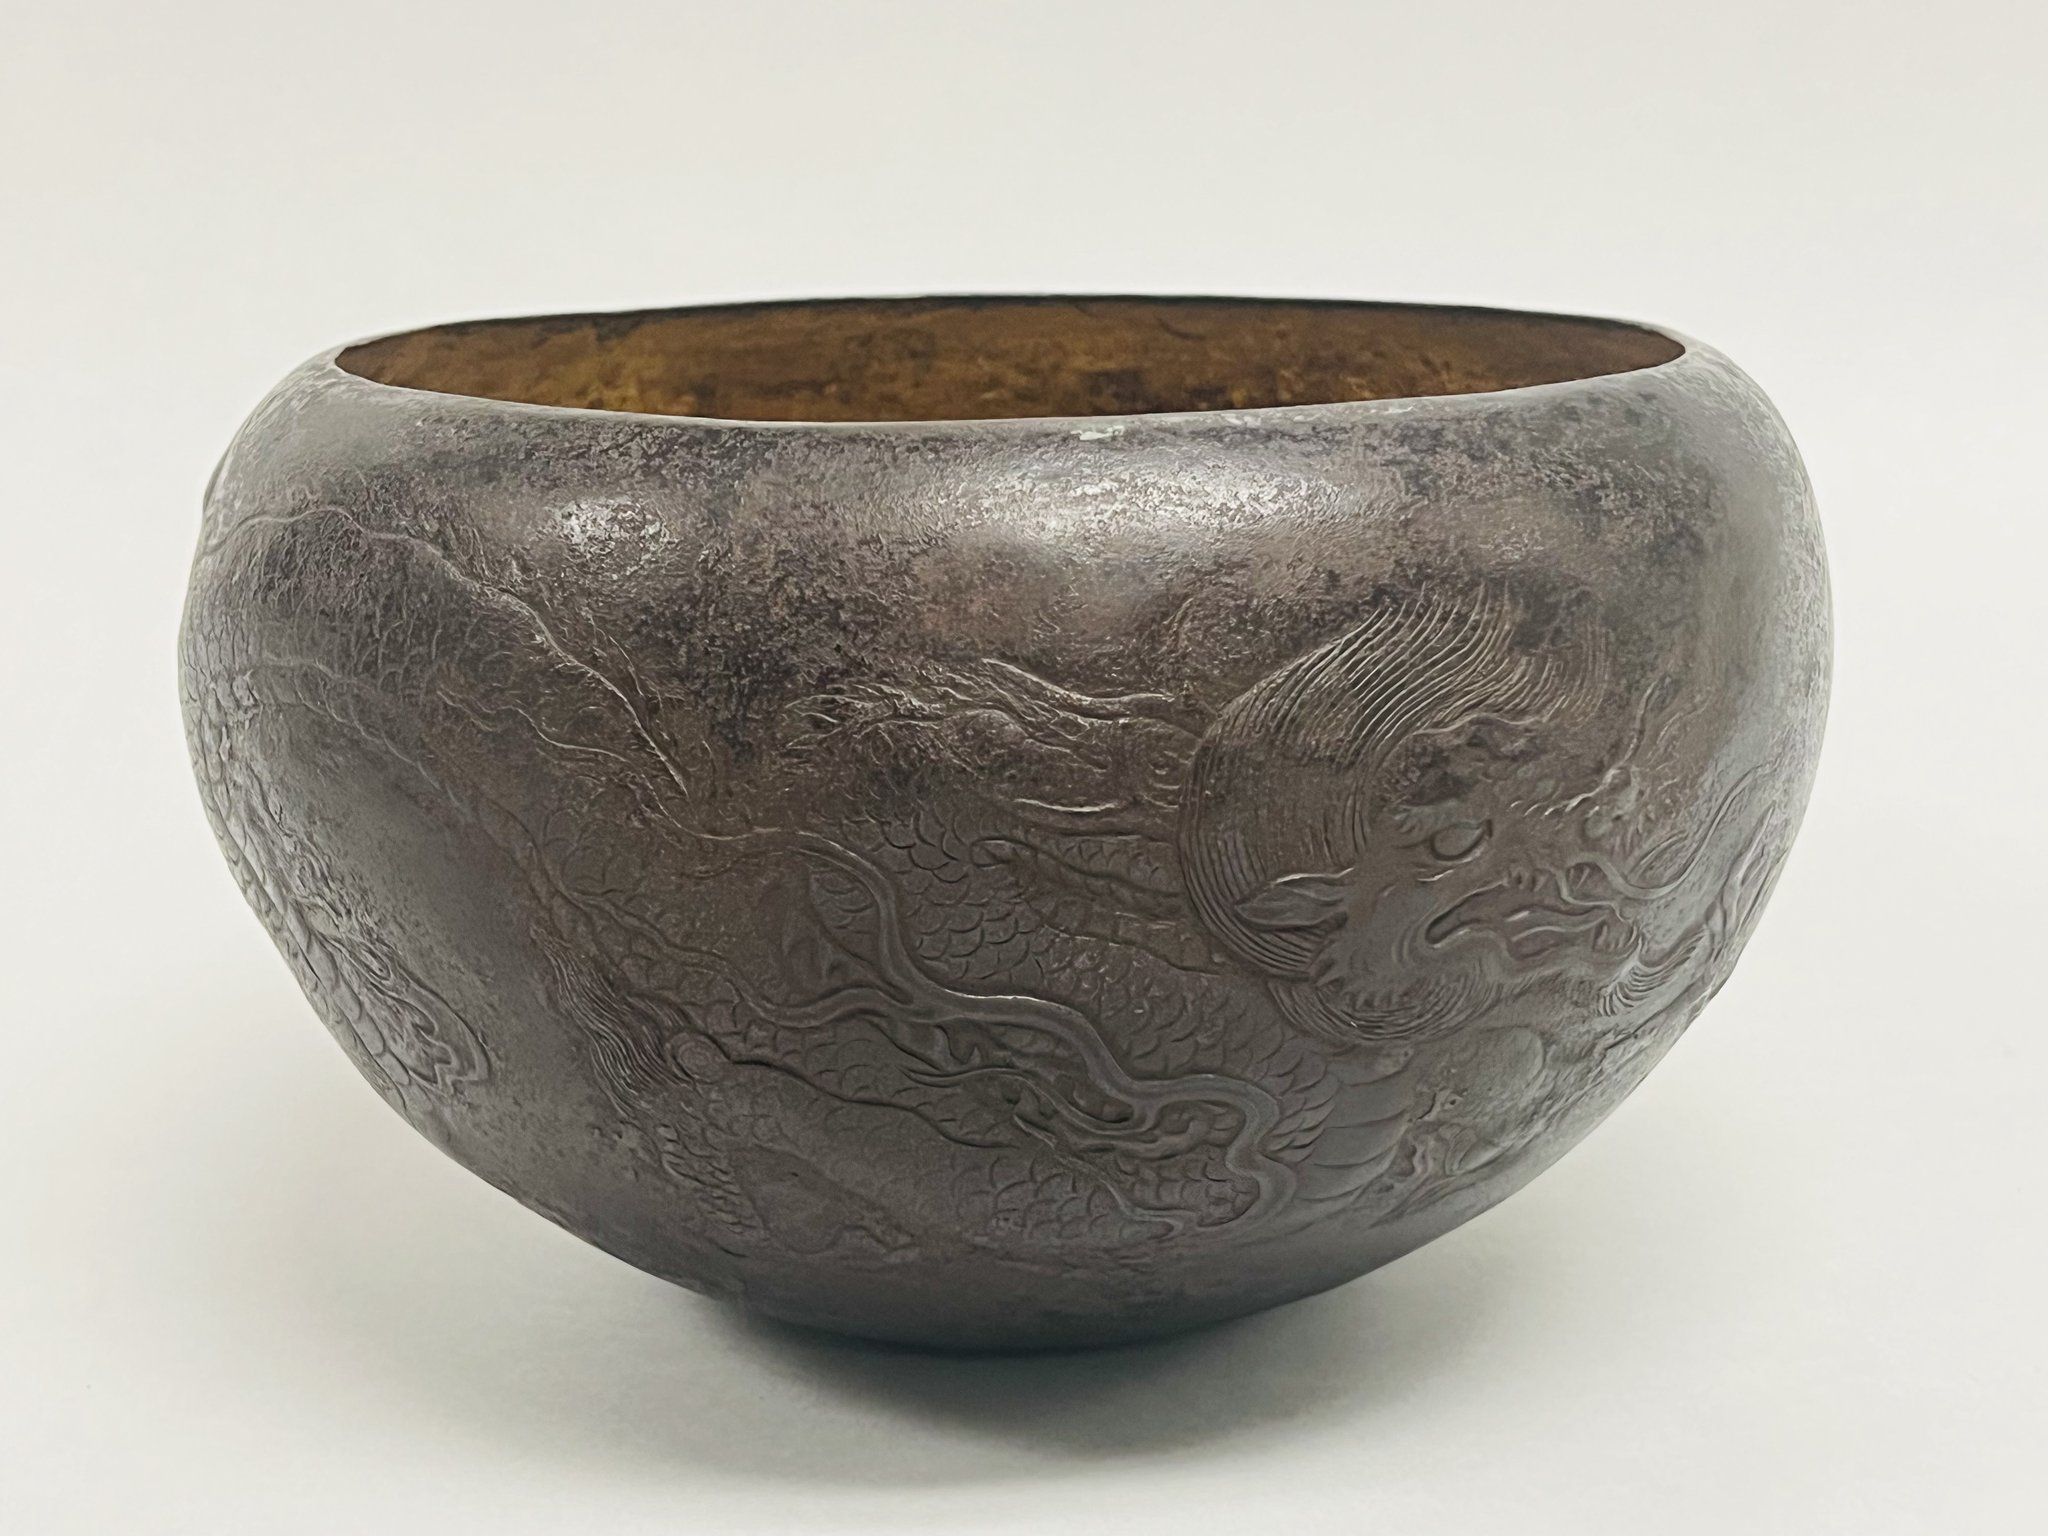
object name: bowl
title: Ritual Bowl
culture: japanese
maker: myōchin munesuke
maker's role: artist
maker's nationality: japanese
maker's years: 1688-1735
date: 1716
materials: gold leaf, iron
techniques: hammering